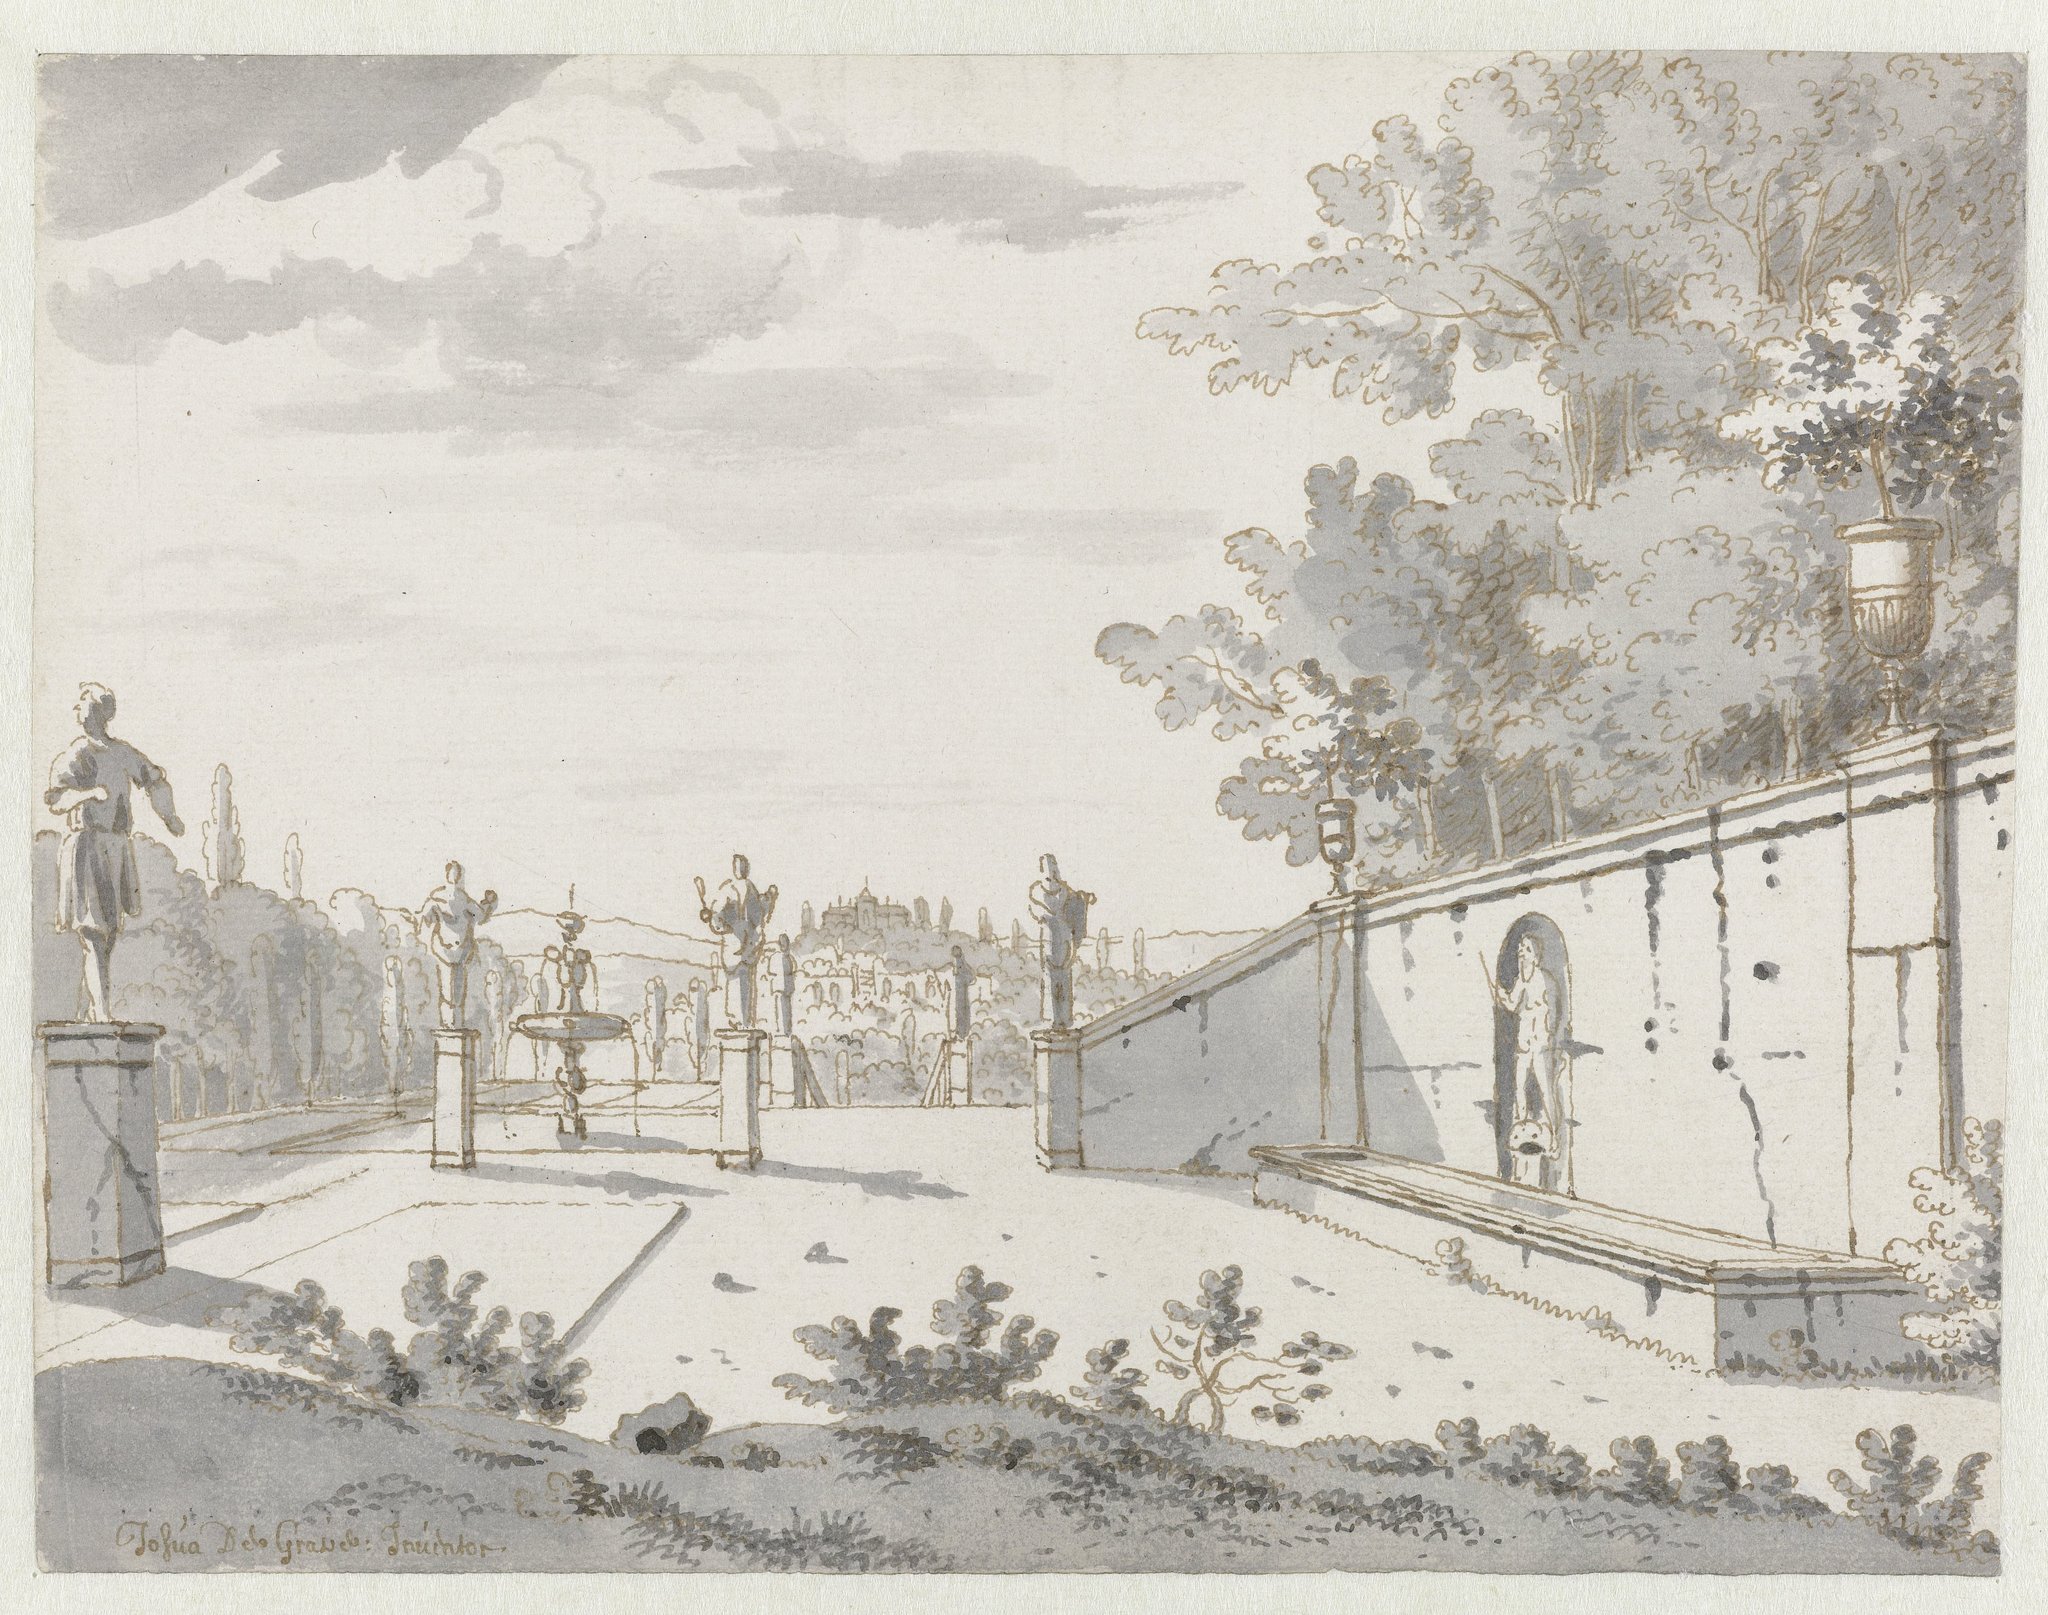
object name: drawing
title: View of an Italianate Sculpture Garden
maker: josua de grave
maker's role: draughtsman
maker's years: 1645-1712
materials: ink, paper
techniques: brush, pen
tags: water-works in garden, statues, sculptures in garden